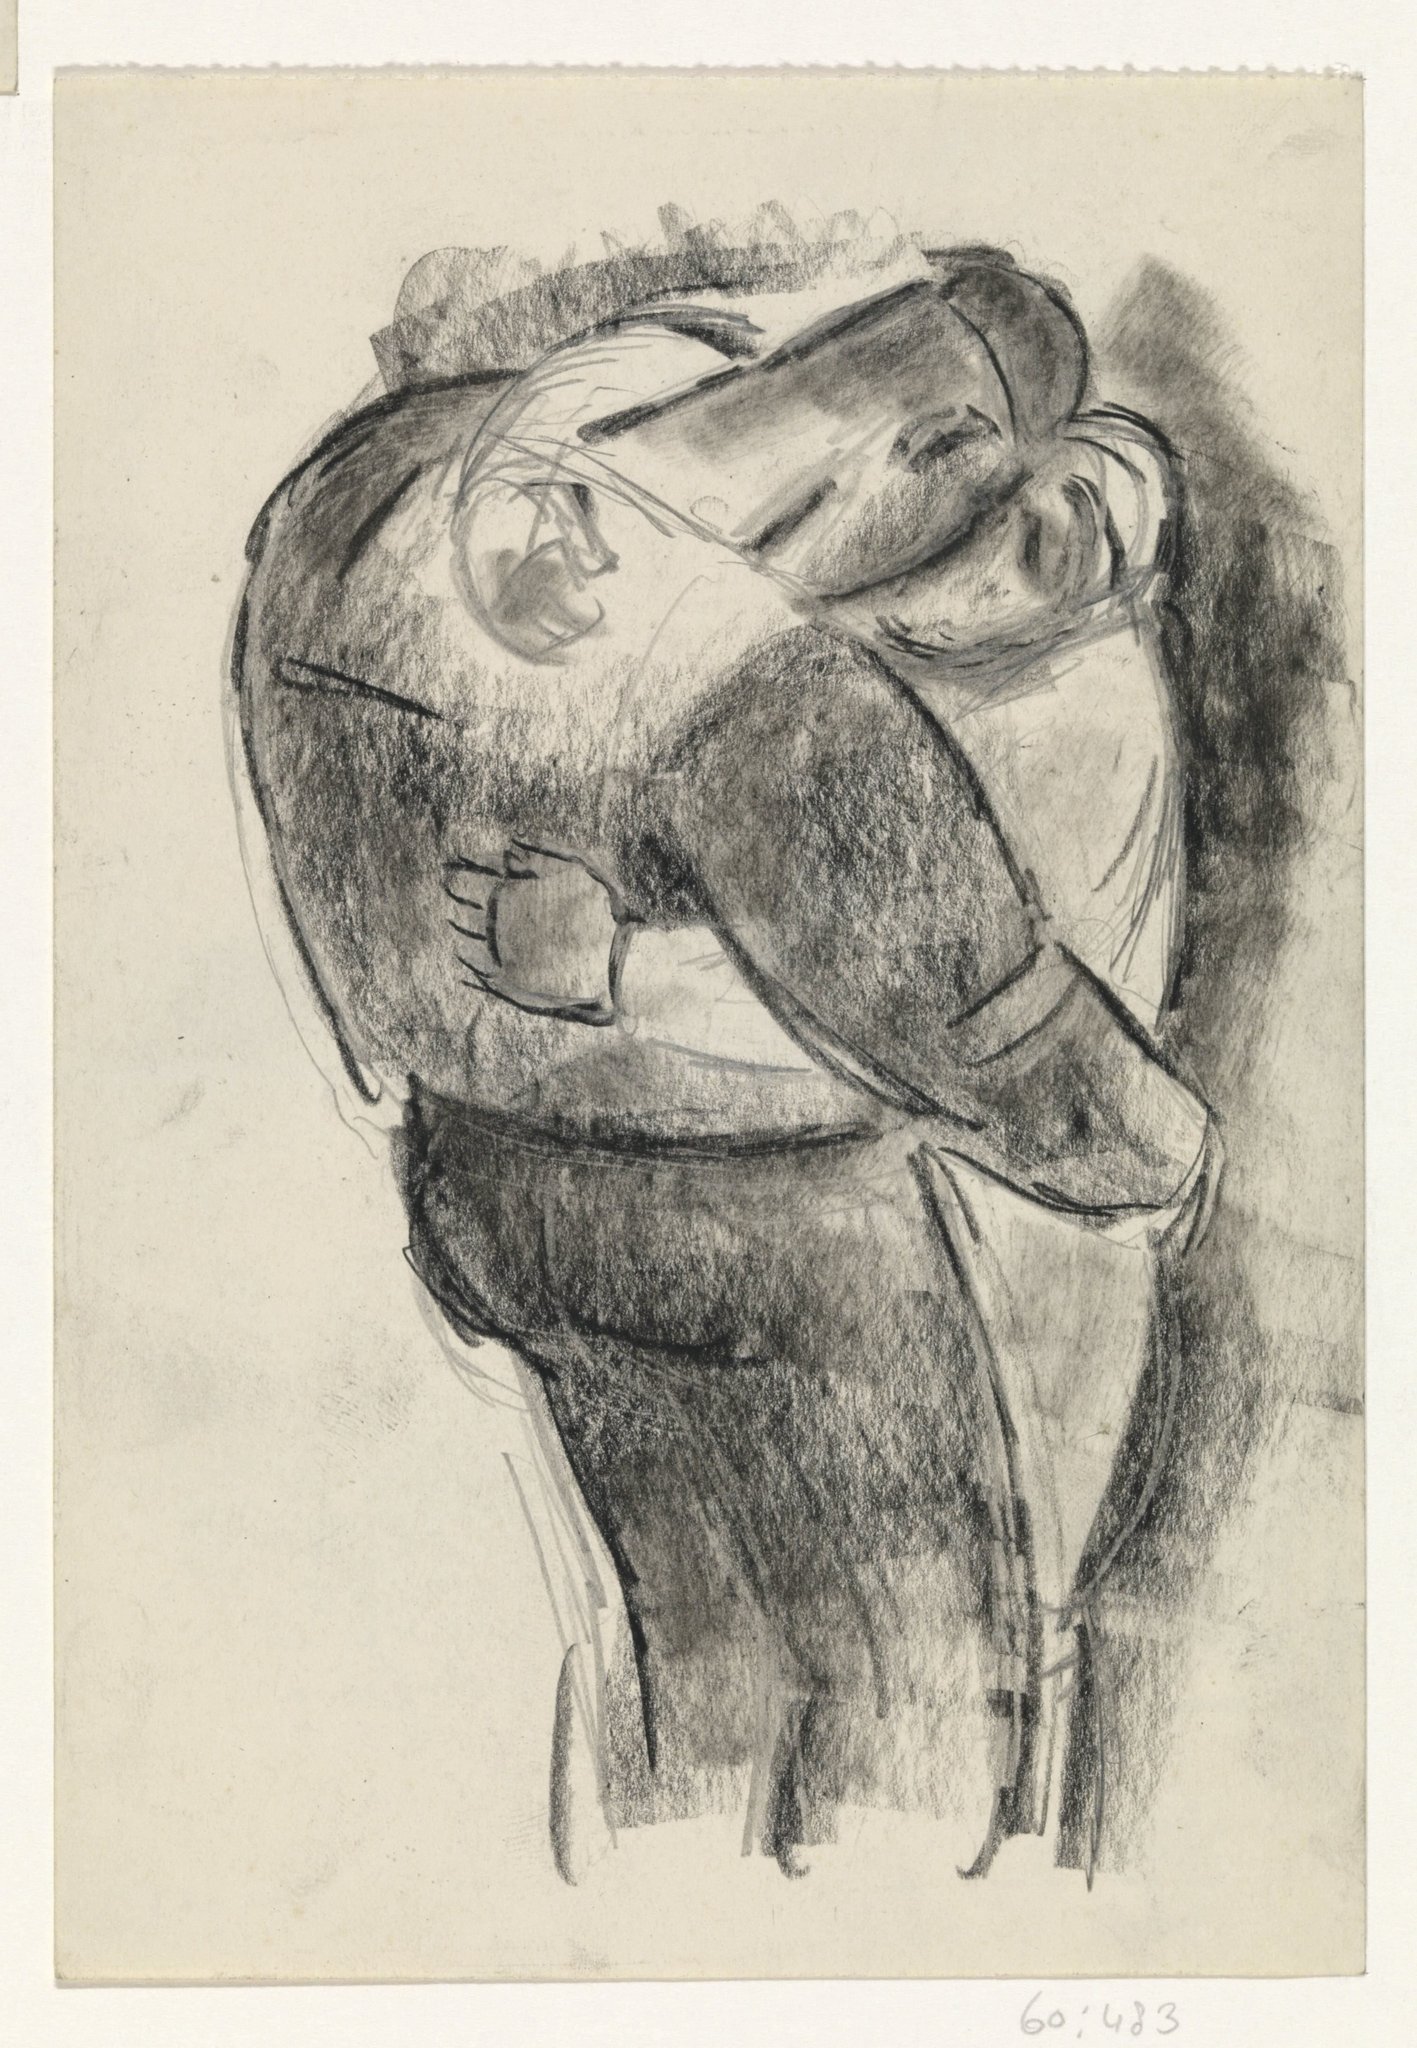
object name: drawing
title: Kussend stel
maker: leo gestel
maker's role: draughtsman, print maker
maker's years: 1881-1941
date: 1891-1941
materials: chalk, paper, pencil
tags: (lovers) kissing each other, embracing each other, kissing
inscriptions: collector's mark: Lugt 2228